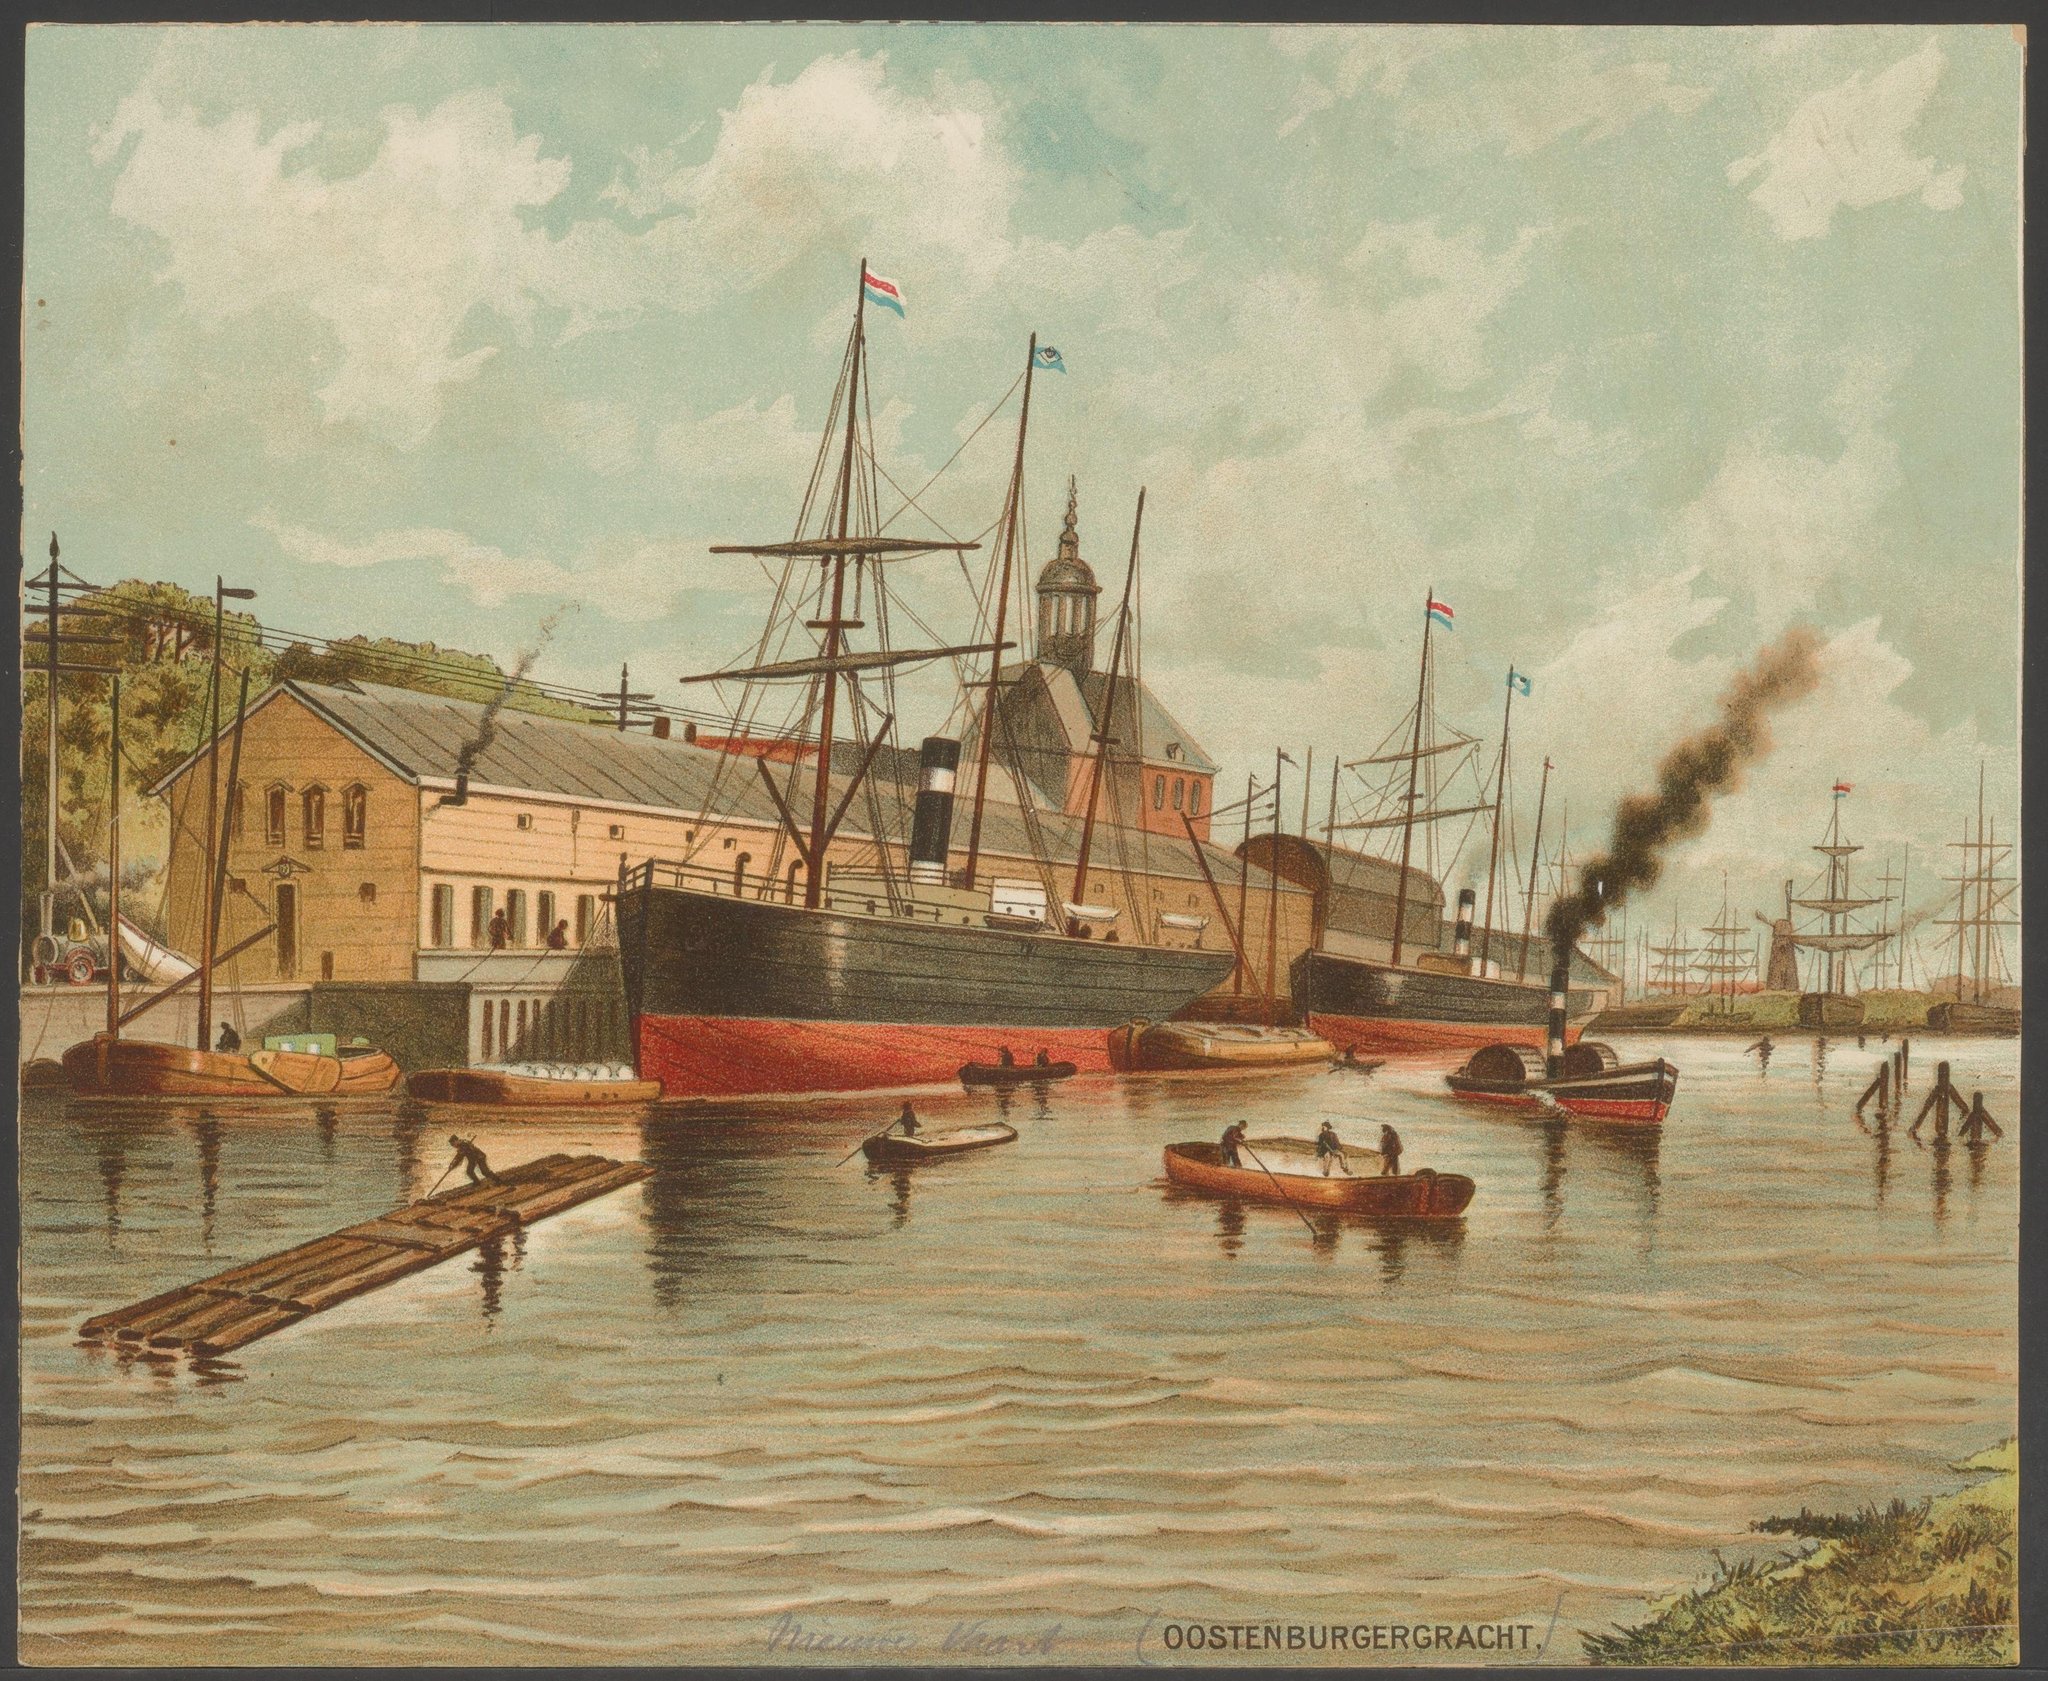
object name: photomechanical print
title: Gezicht op de Oostenburgergracht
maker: Anonymous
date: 1875-1975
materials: paper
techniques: line block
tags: city-view in general; 'veduta', canal, ships (in general) - cc - more than one ship, boat propelled by man or animal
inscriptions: collector's mark: ‘10.92’ Lugt 1641b, inscription: ‘Nieuwe Vaart’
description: Onderwerpsrubriek binnen de Atlas Amsterdam: Oetgensstraat, Olifantspad, Olofspoort (St.), Onkelboerensteeg, Oosterparkstraat, Oostenburgergracht, Oosterdoksdijk, Osjessluis en Kalverstraat, Ossenspooksteeg, Oudekerksplein, Oudemanhuispoort, Oude Schans.